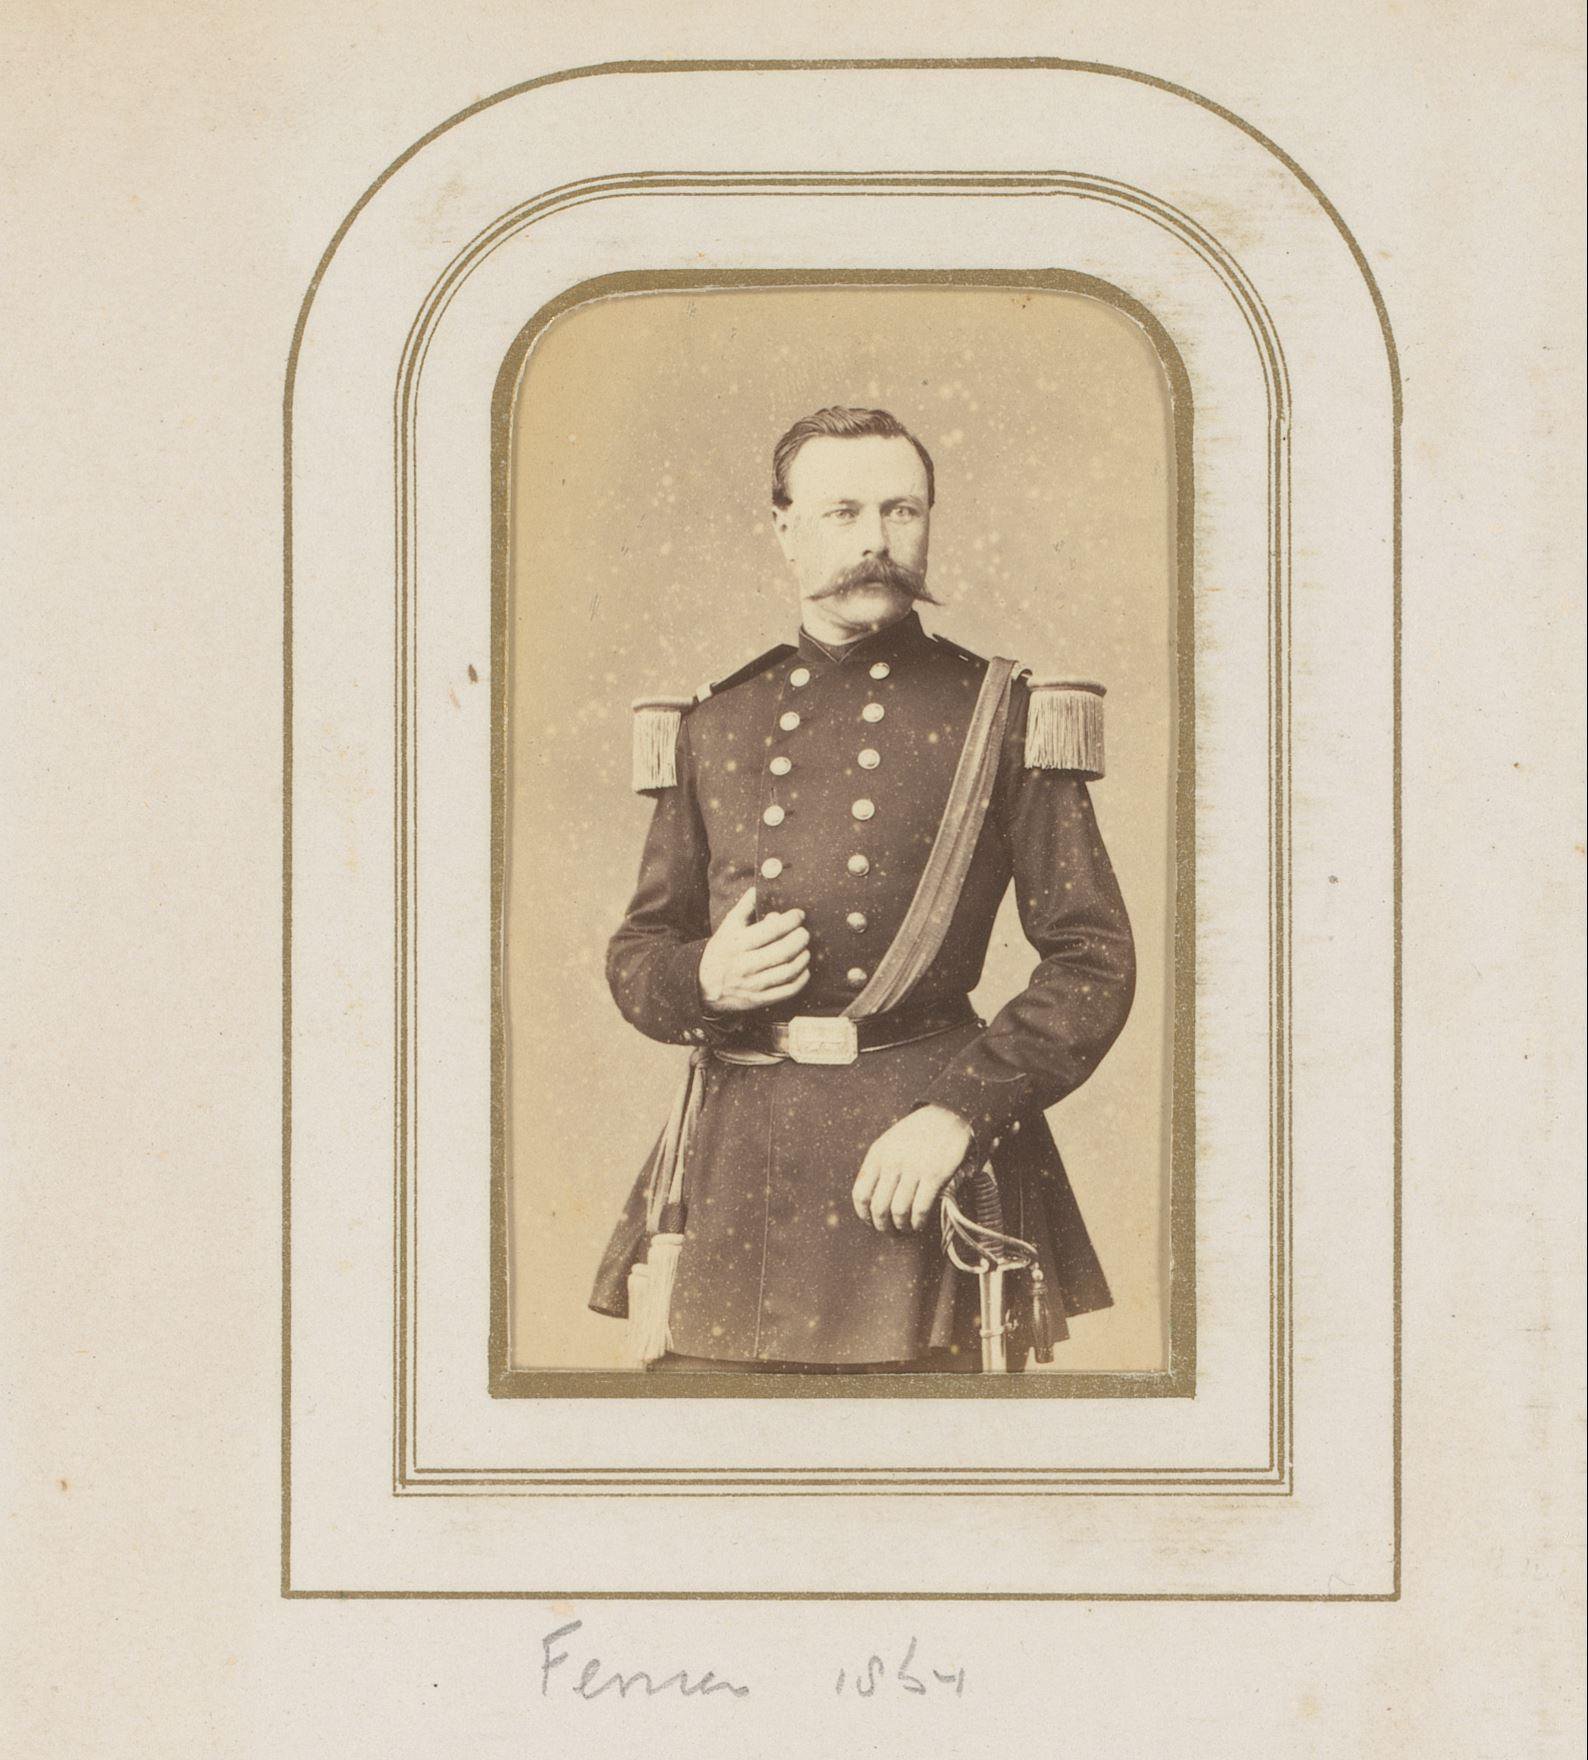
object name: carte de visite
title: Portret van een man met snor in uniform, aangeduid als Ferrier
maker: joseph maes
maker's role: fotograaf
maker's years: 1838-1908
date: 1863-1866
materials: cardboard, photographic support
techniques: albumen print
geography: brussels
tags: moustache, historical persons, (military) uniforms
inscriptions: annotation: ‘A mon ami Lemoine/ capitaine, Aide-de-Camp-Bruxelles, le 25 mai 1864/ le cape d'haut-major/ [Ed Ferrier]’, inscription: ‘J. Maes/ Place de la Monnaie/ 36, Rue Fossé-aux-Loups/ Bruxelles’